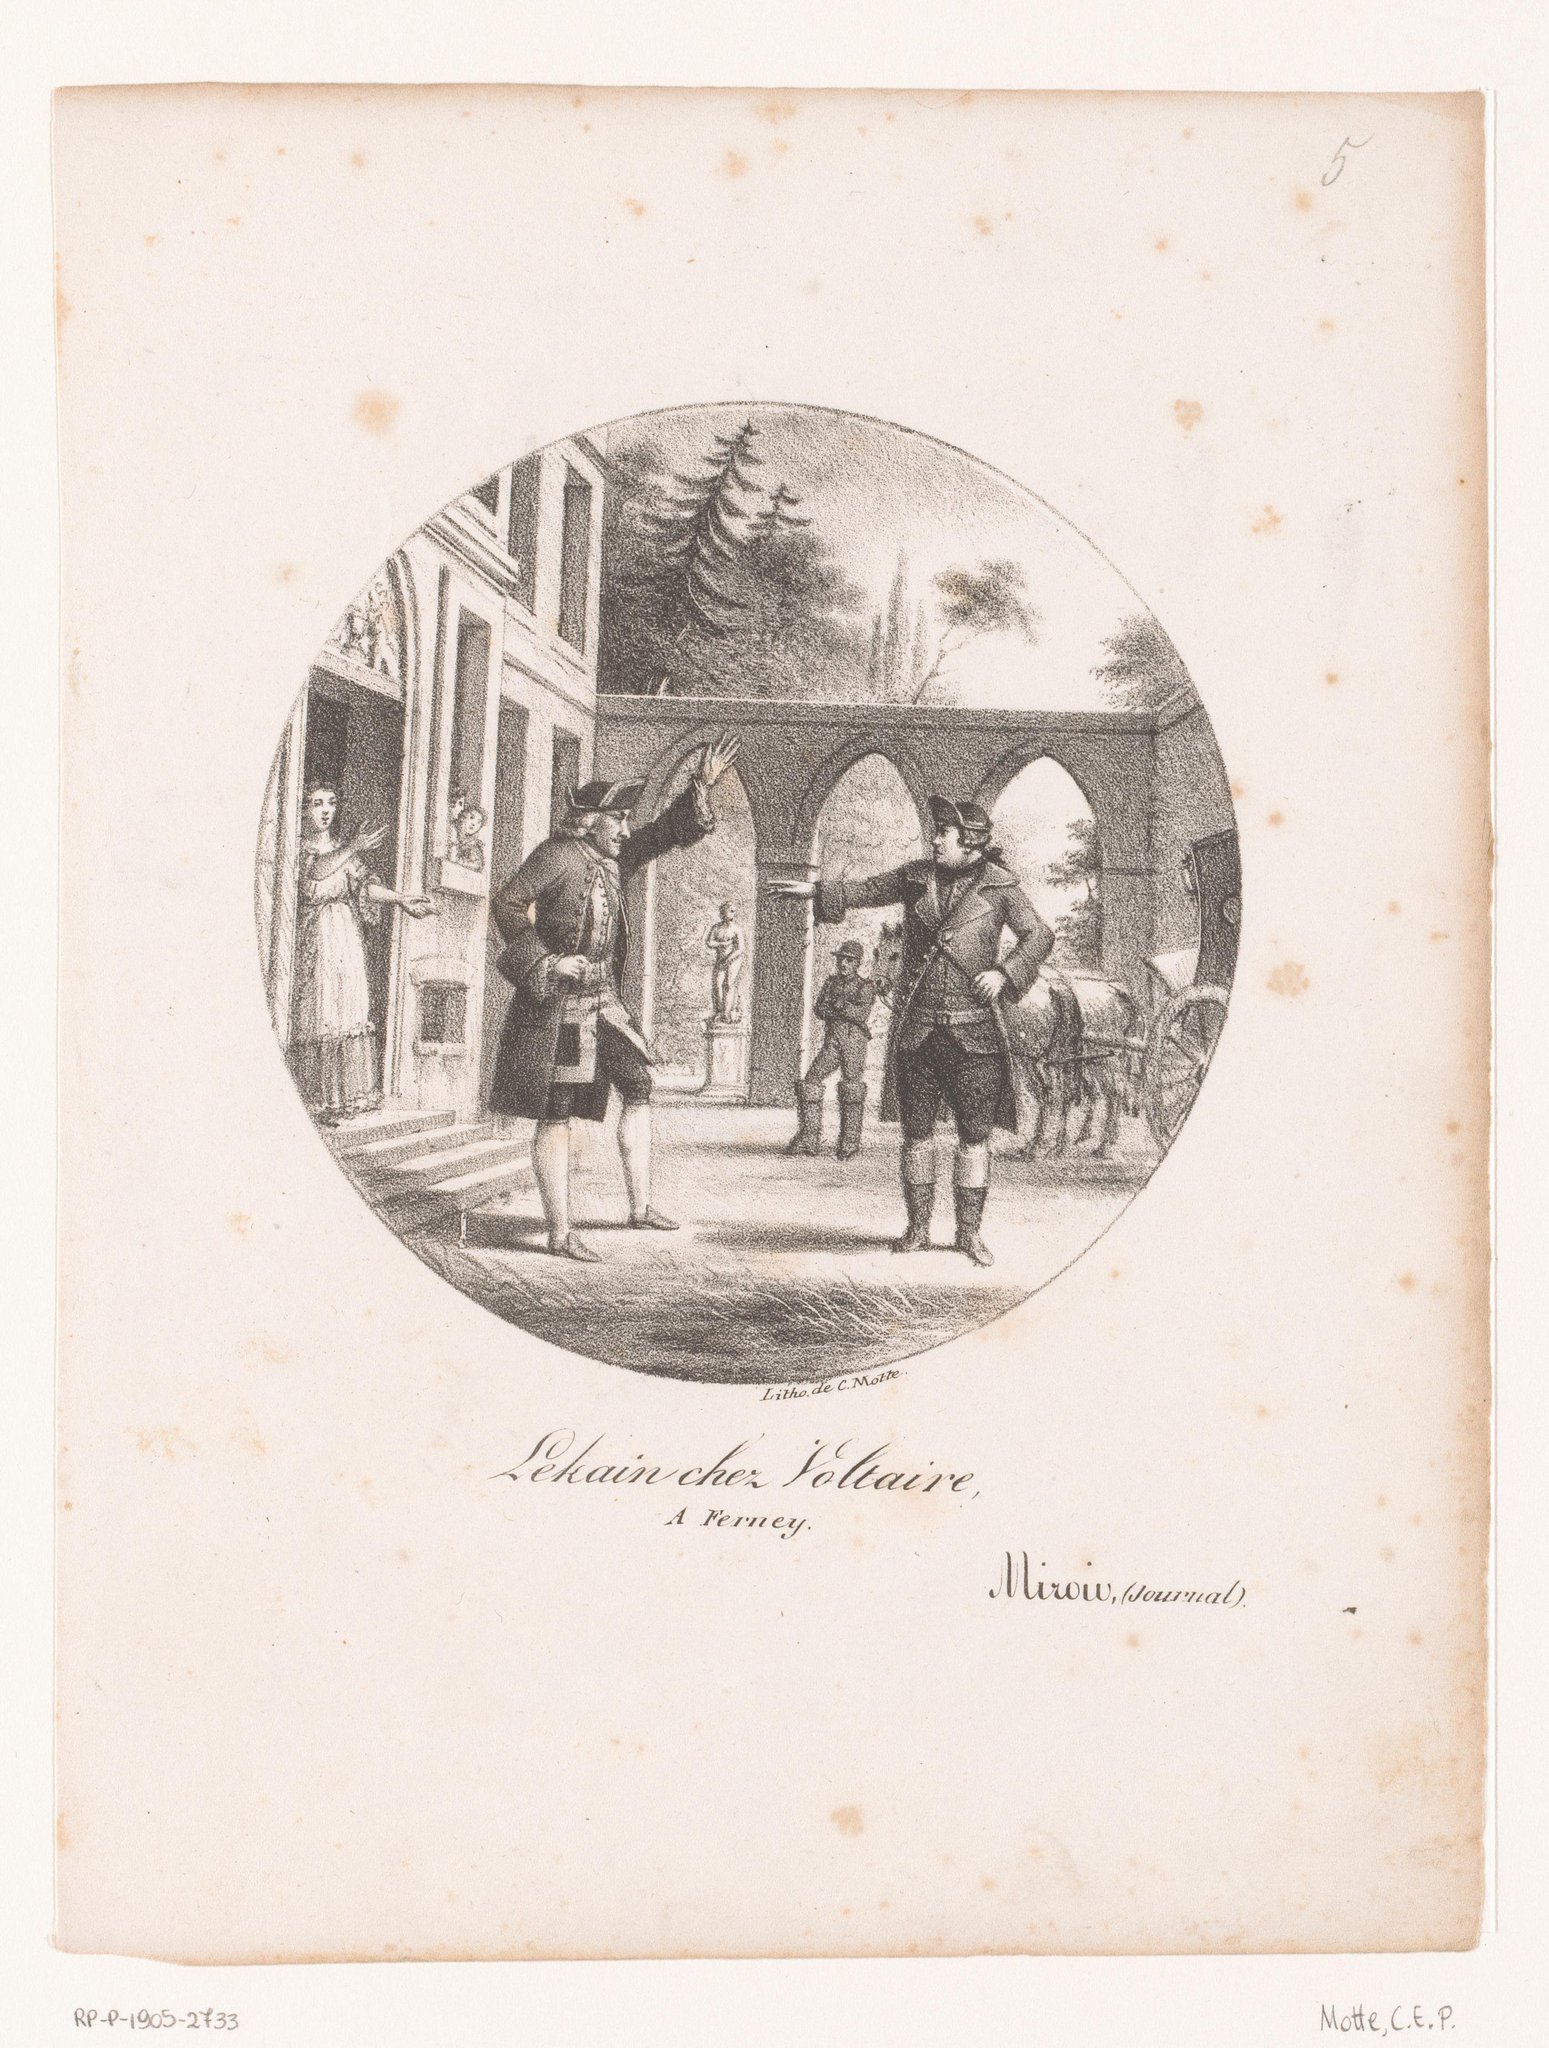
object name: print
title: Lekain en Voltaire bij het kasteel van Voltaire in Ferney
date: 1821-1823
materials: paper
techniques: lithograph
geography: paris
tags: paris, voltaire, castle, writer, poet, author, actor, actress (non-work situations)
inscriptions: collector's mark: Lugt 2228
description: Prent gebruikt in: Le Miroir des spectacles, des lettres, des mœurs et des arts, 1821-1823.